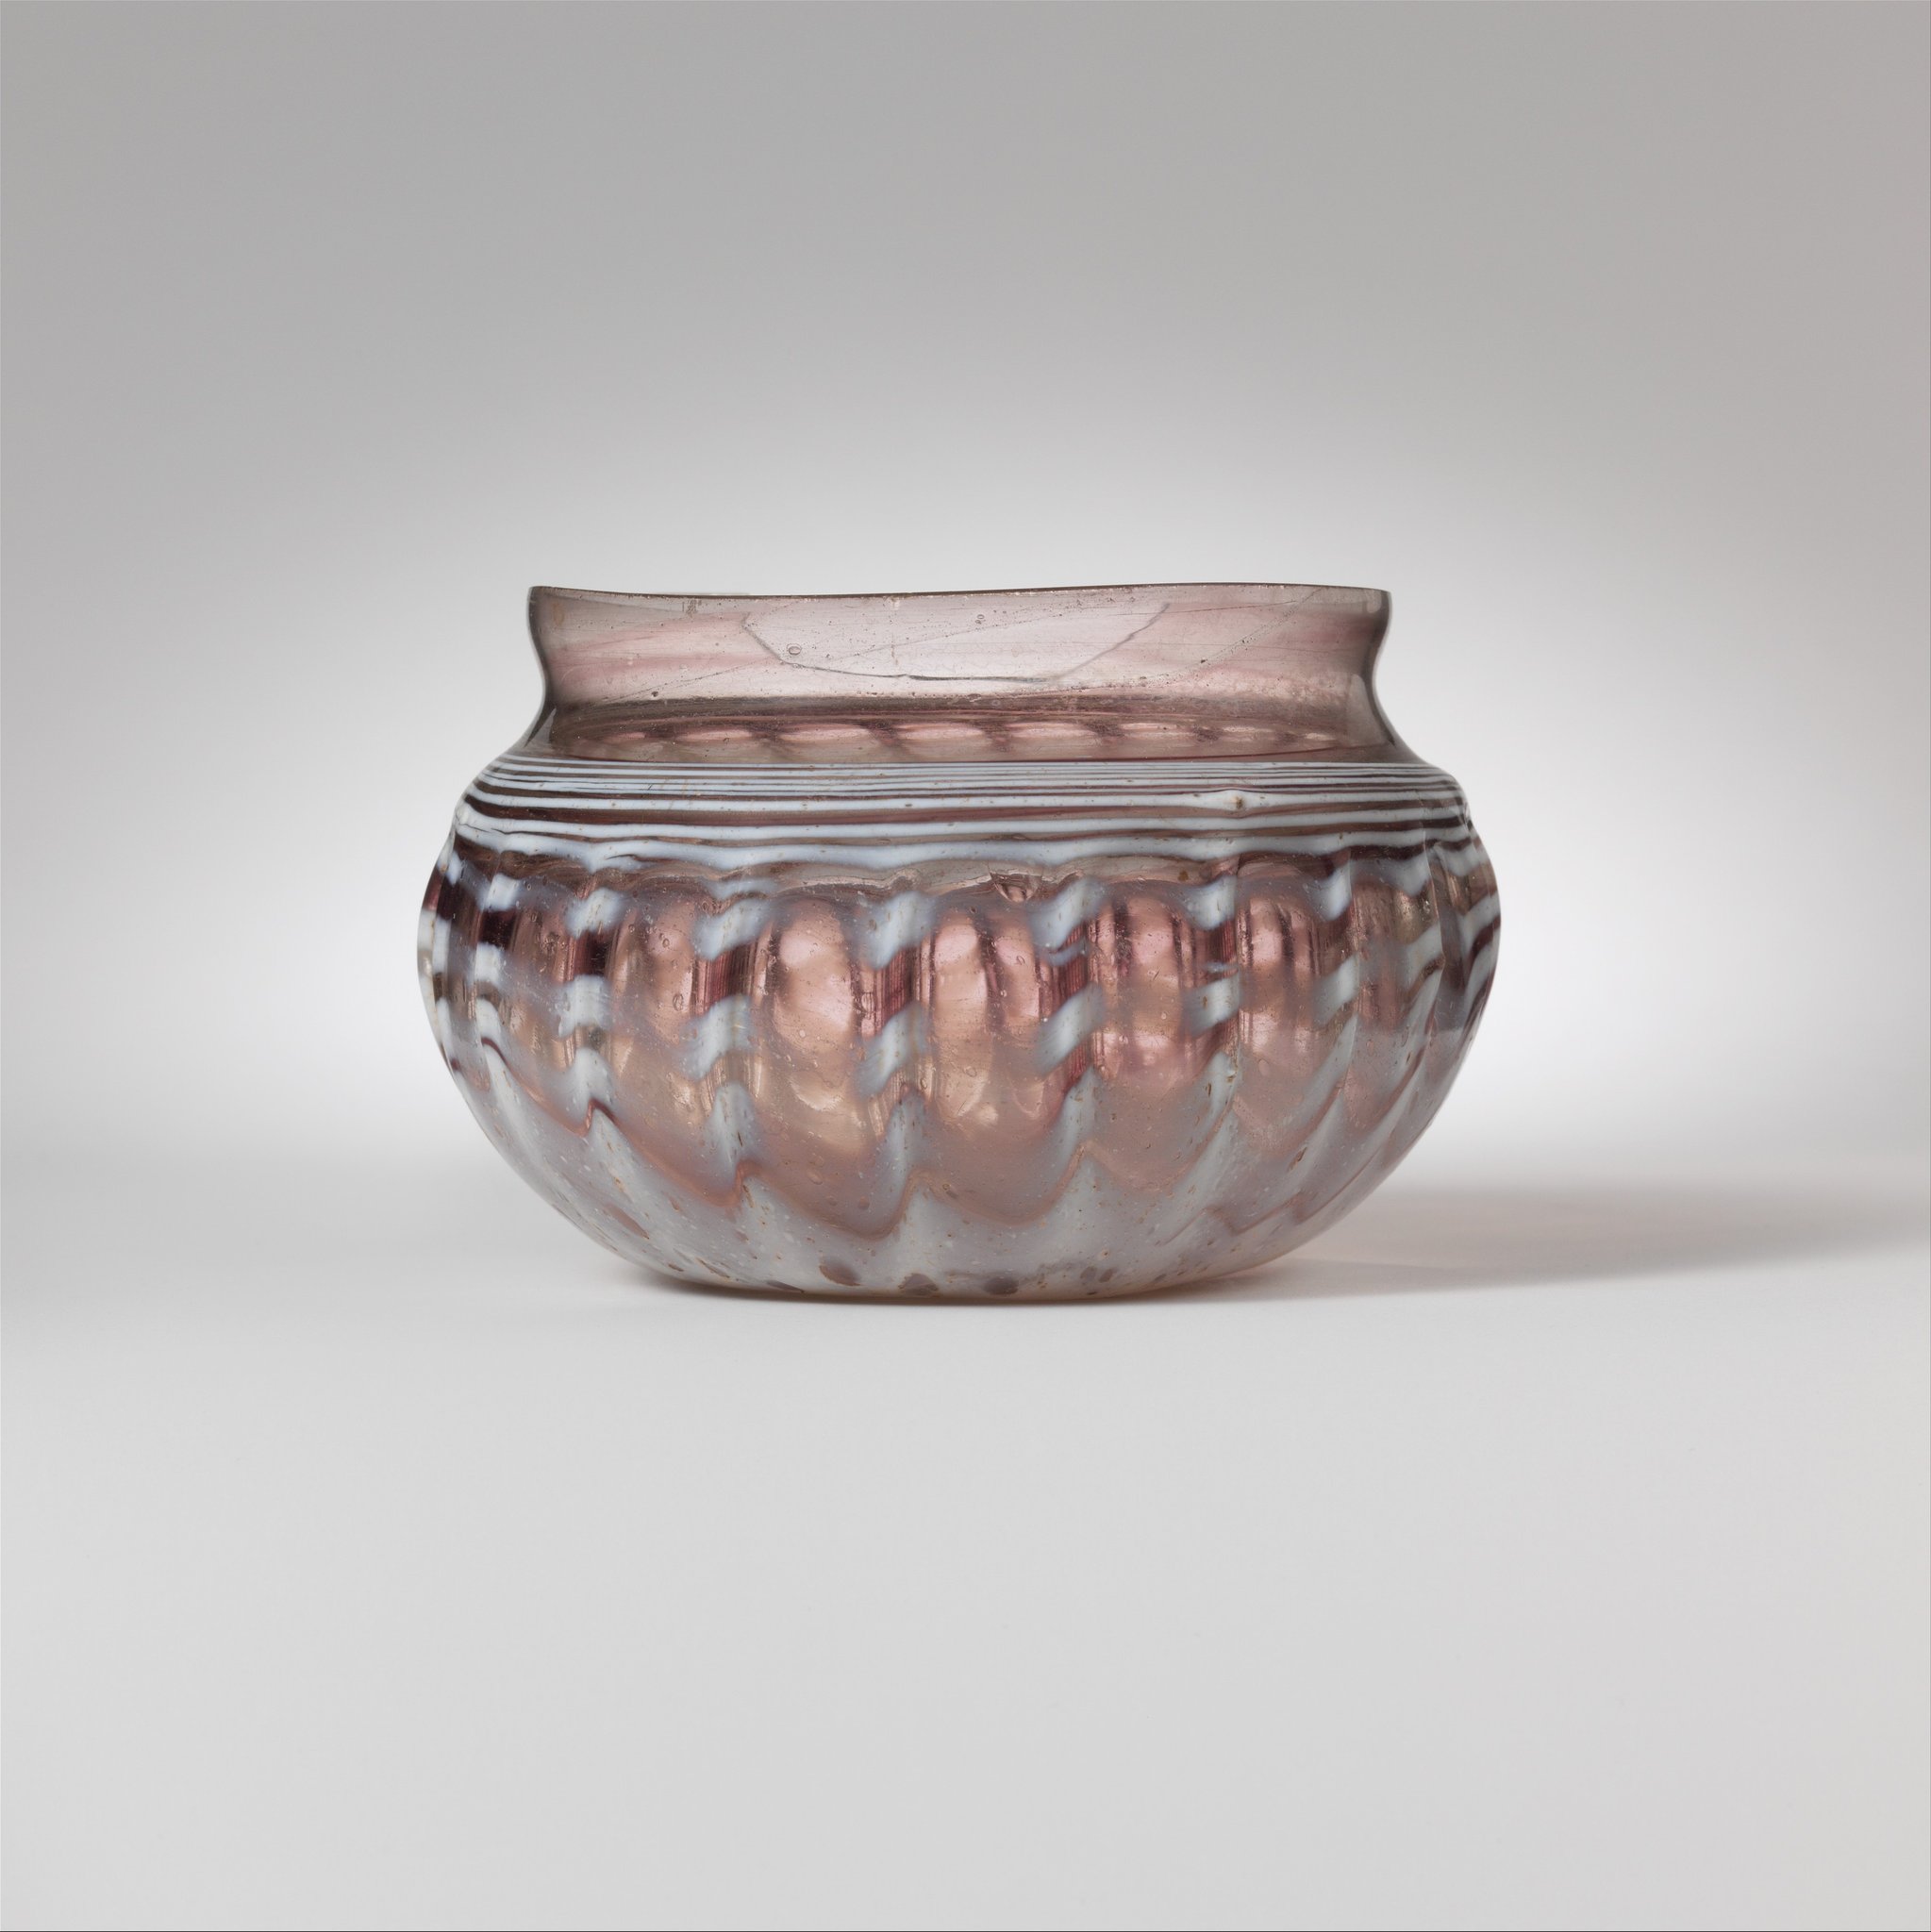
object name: bowl, rippenschale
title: Glass ribbed bowl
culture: roman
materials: glass